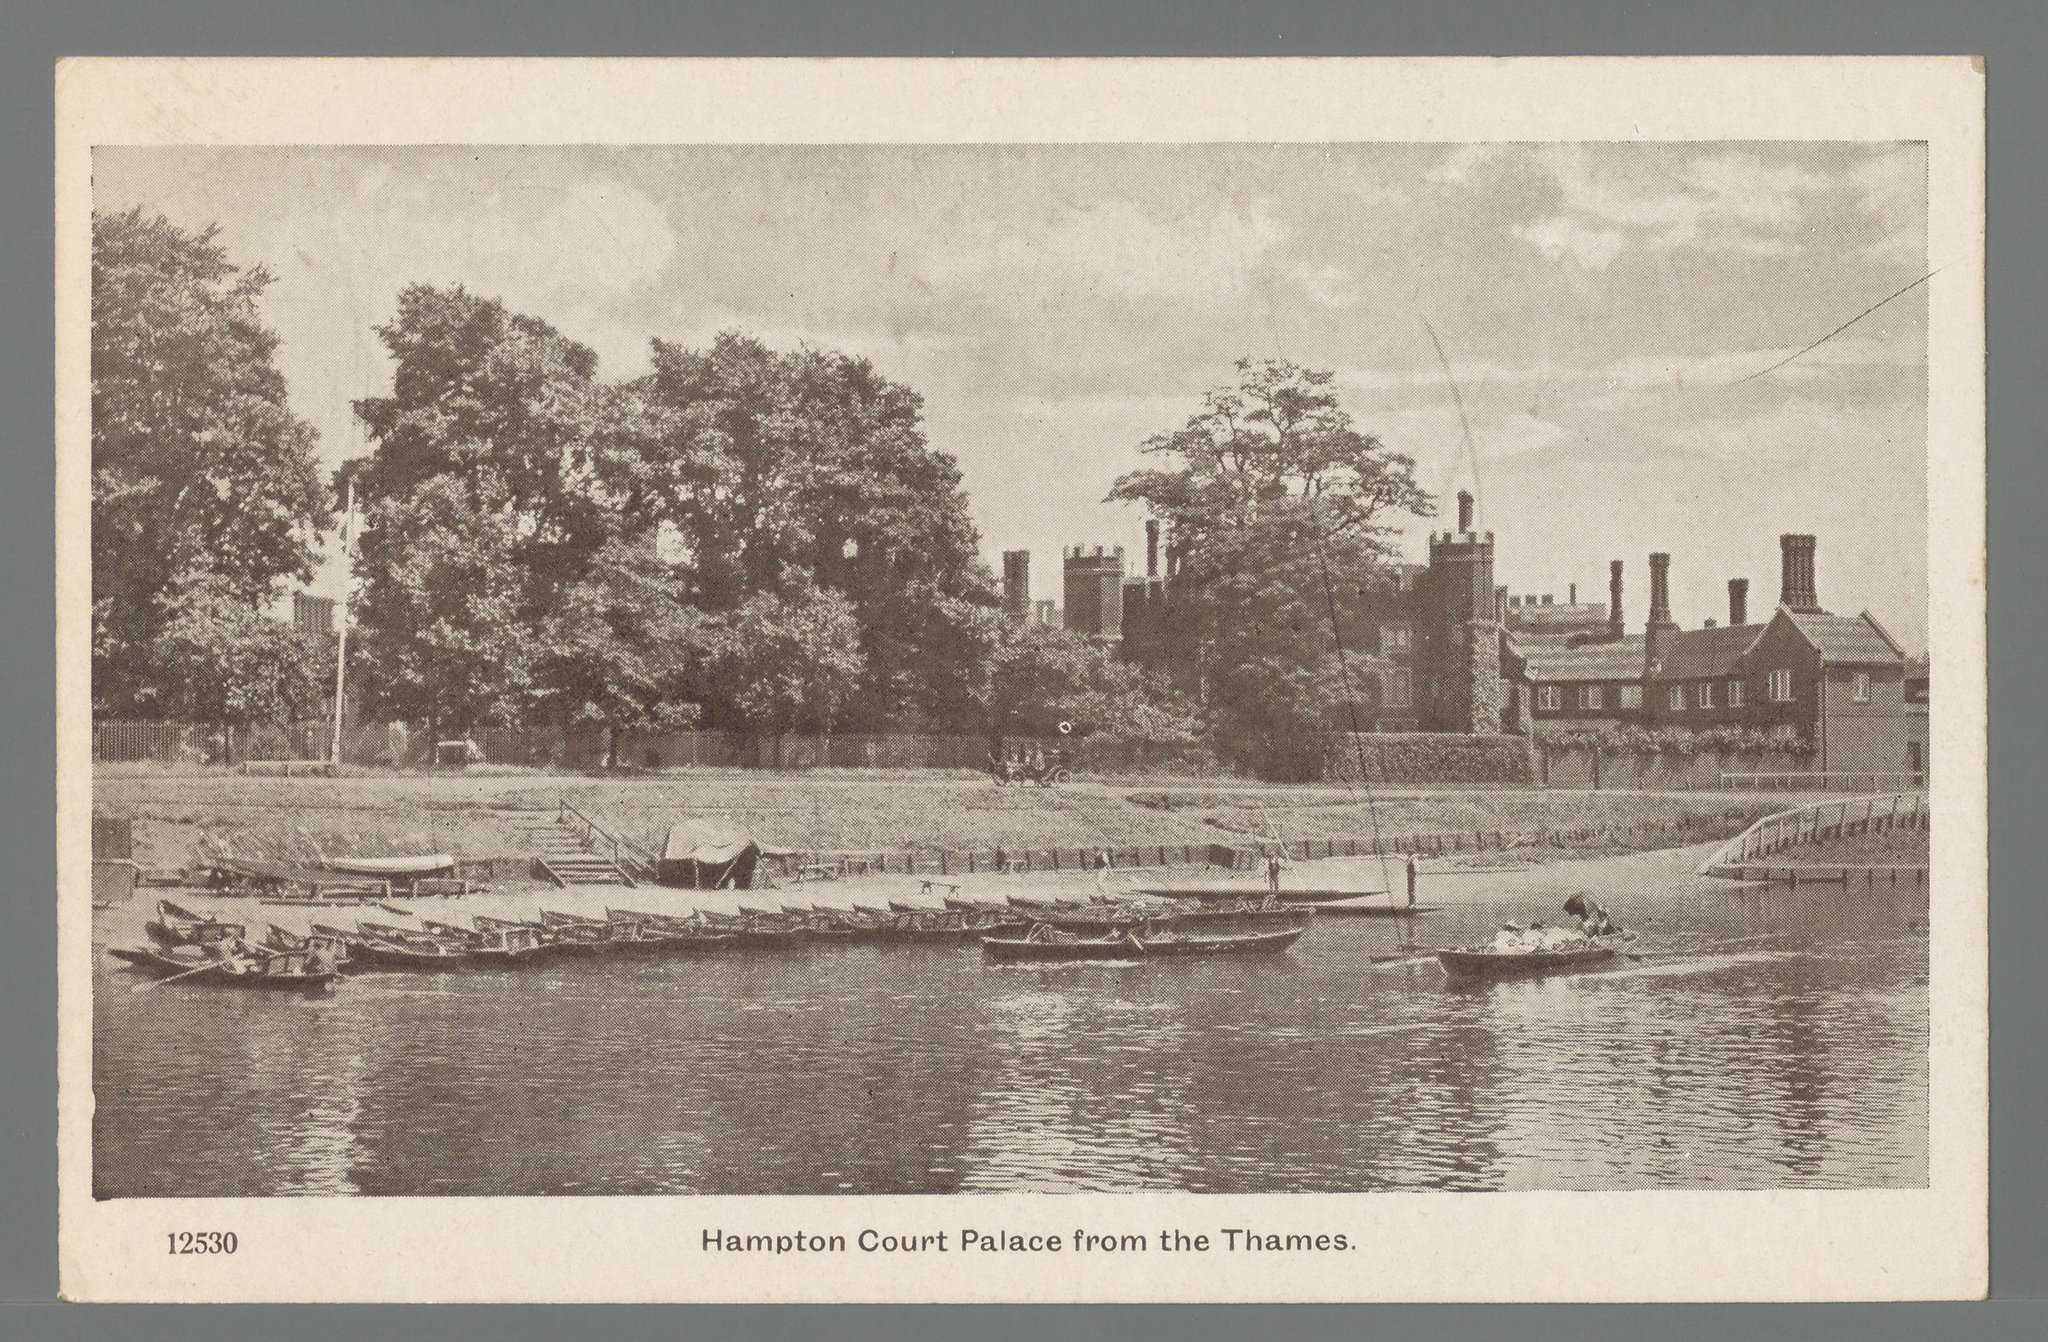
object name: photomechanical print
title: Hampton Court Palace from the Thames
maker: Anonymous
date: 1915-1930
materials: cardboard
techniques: autotype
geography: london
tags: river, palace, thames